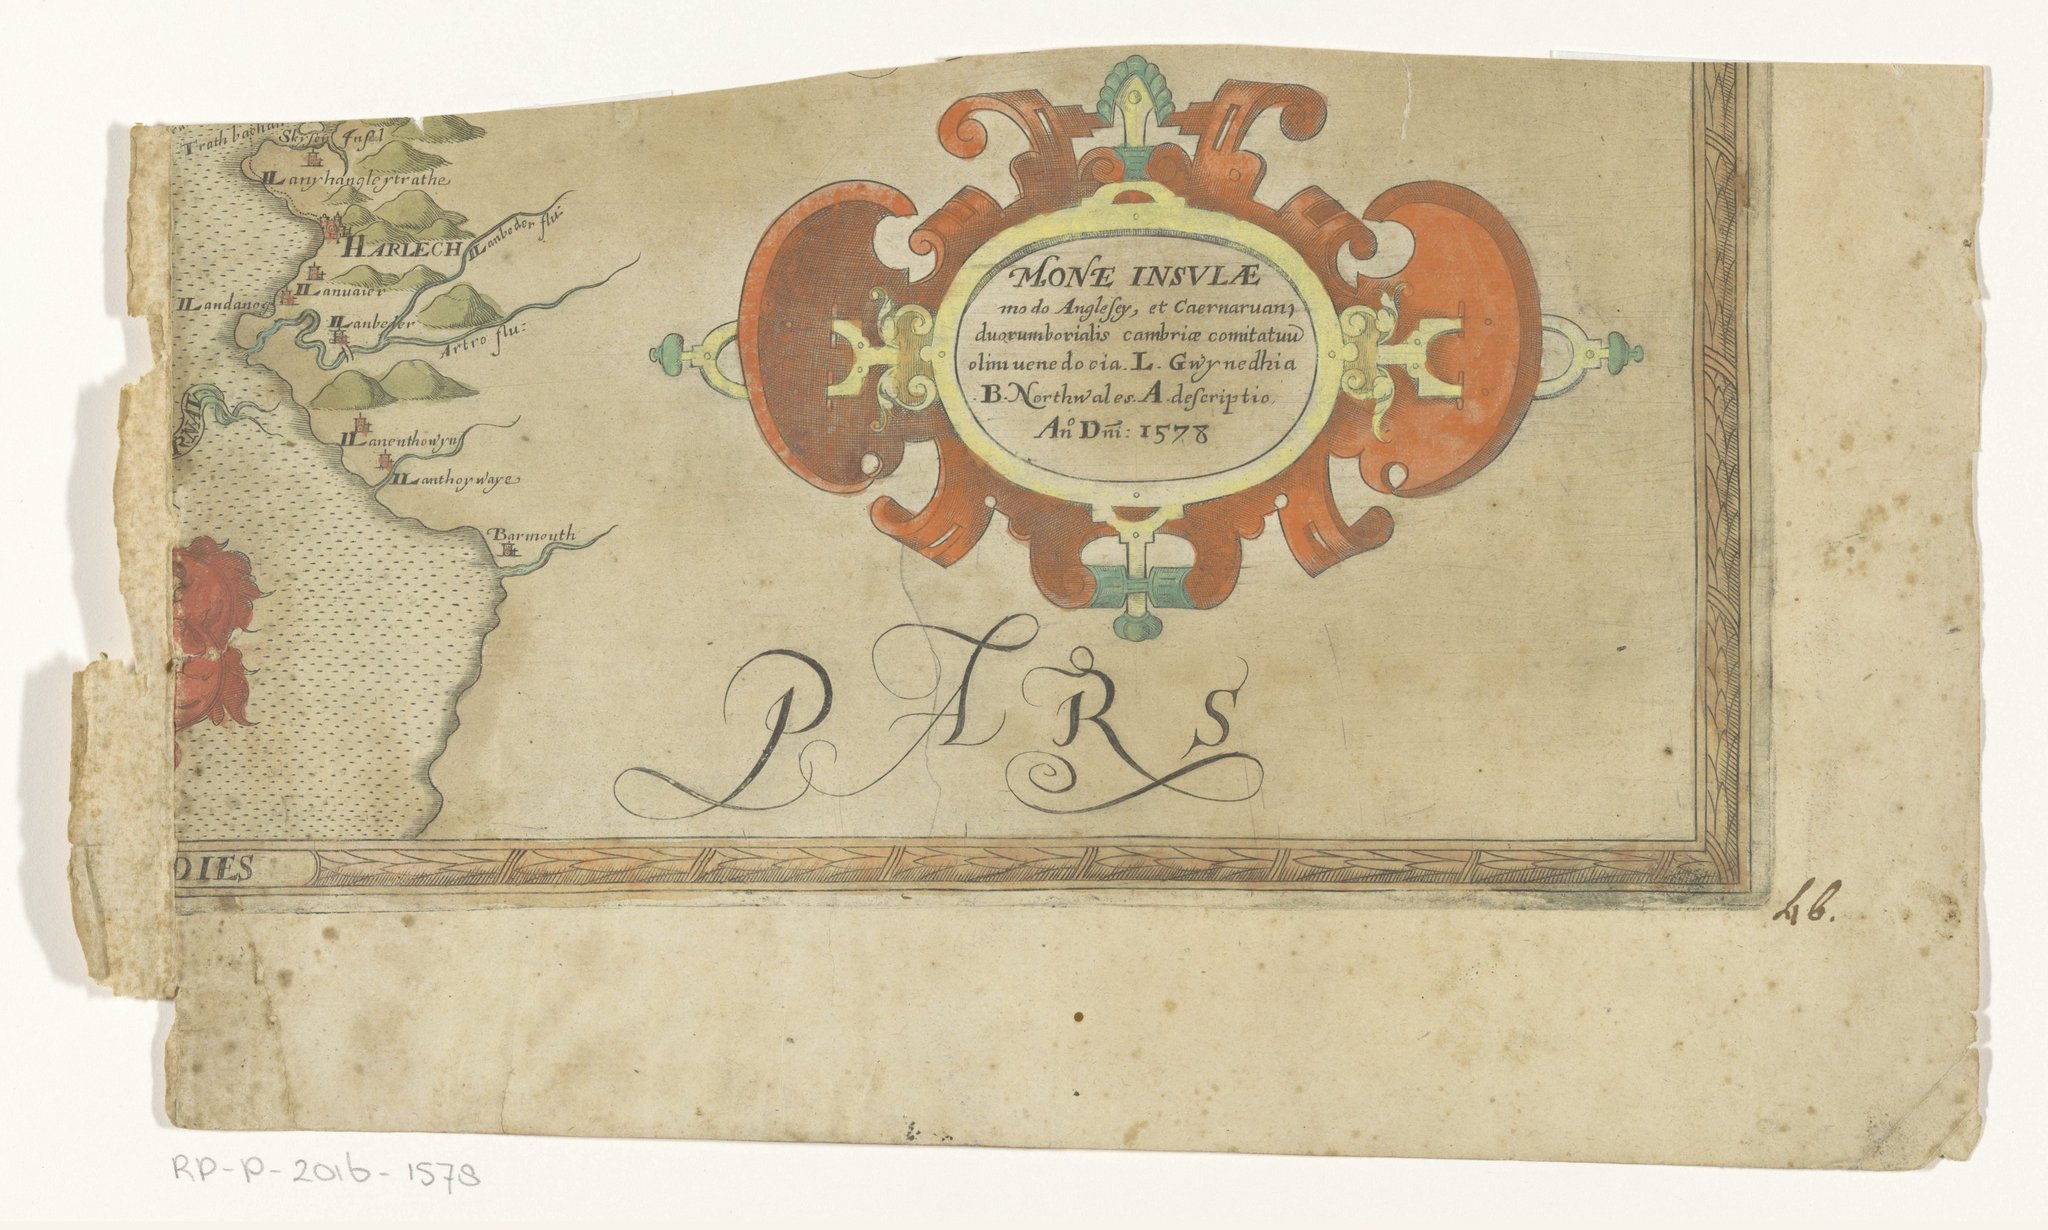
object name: print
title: Cartouche met rolwerk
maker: Anonymous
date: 1578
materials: paper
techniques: engraving, hand coloring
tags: scrollwork, strapwork ~ ornament, ornament ~ cartouche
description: Een cartouche met rolwerk en titel. Detail van een kaart van de historische graafschappen Anglesey en Caernarvonshire in het noordwesten van Wales.